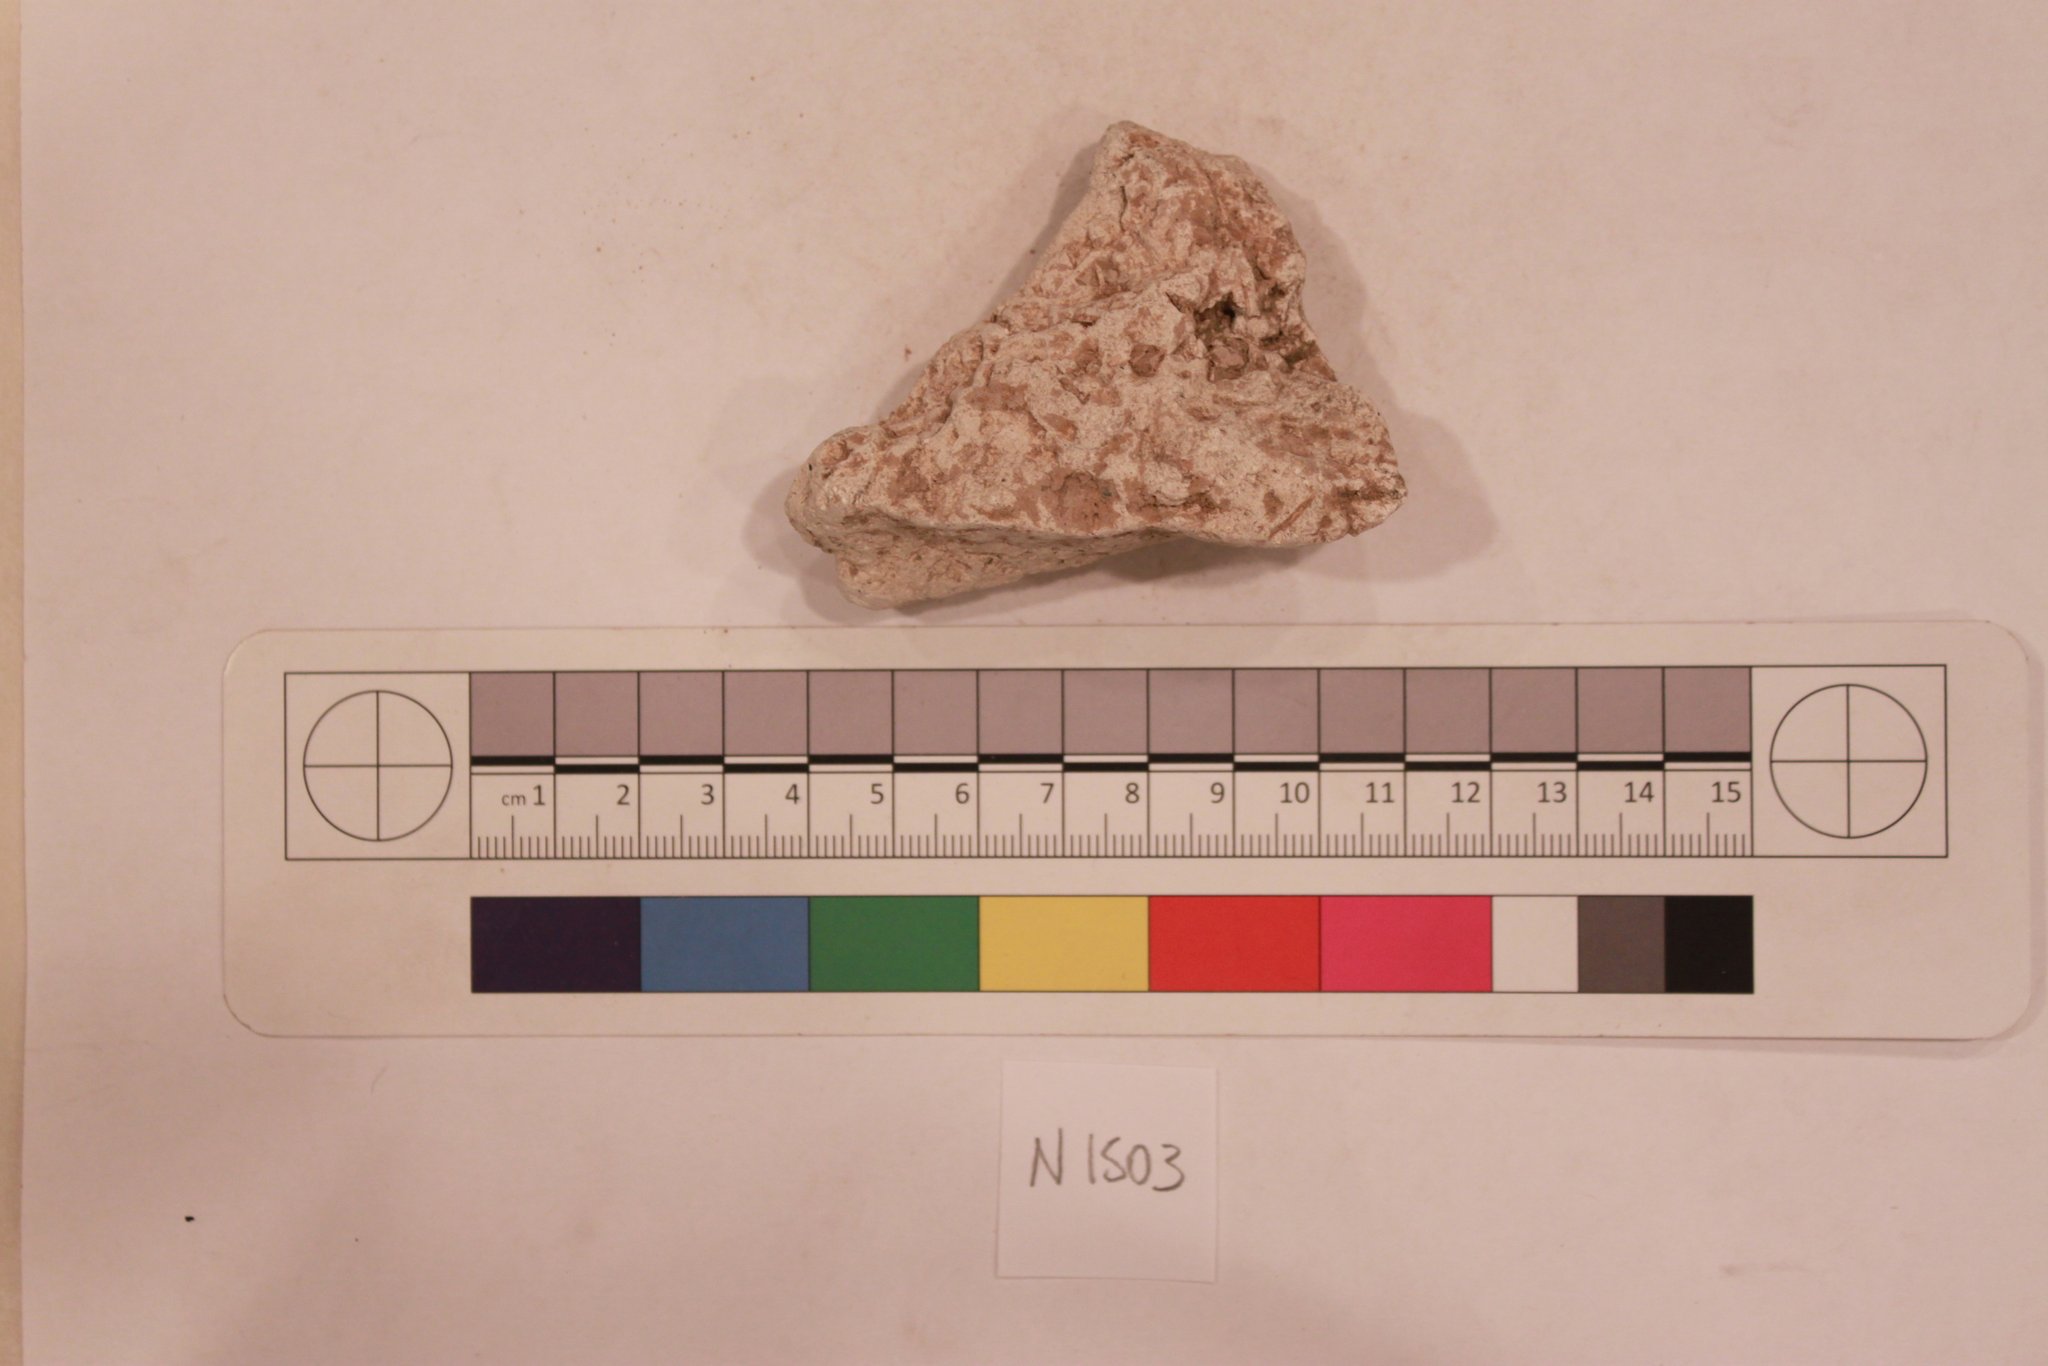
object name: fragment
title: Stucco Fragment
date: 701-1200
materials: plaster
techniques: carving, painting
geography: iran